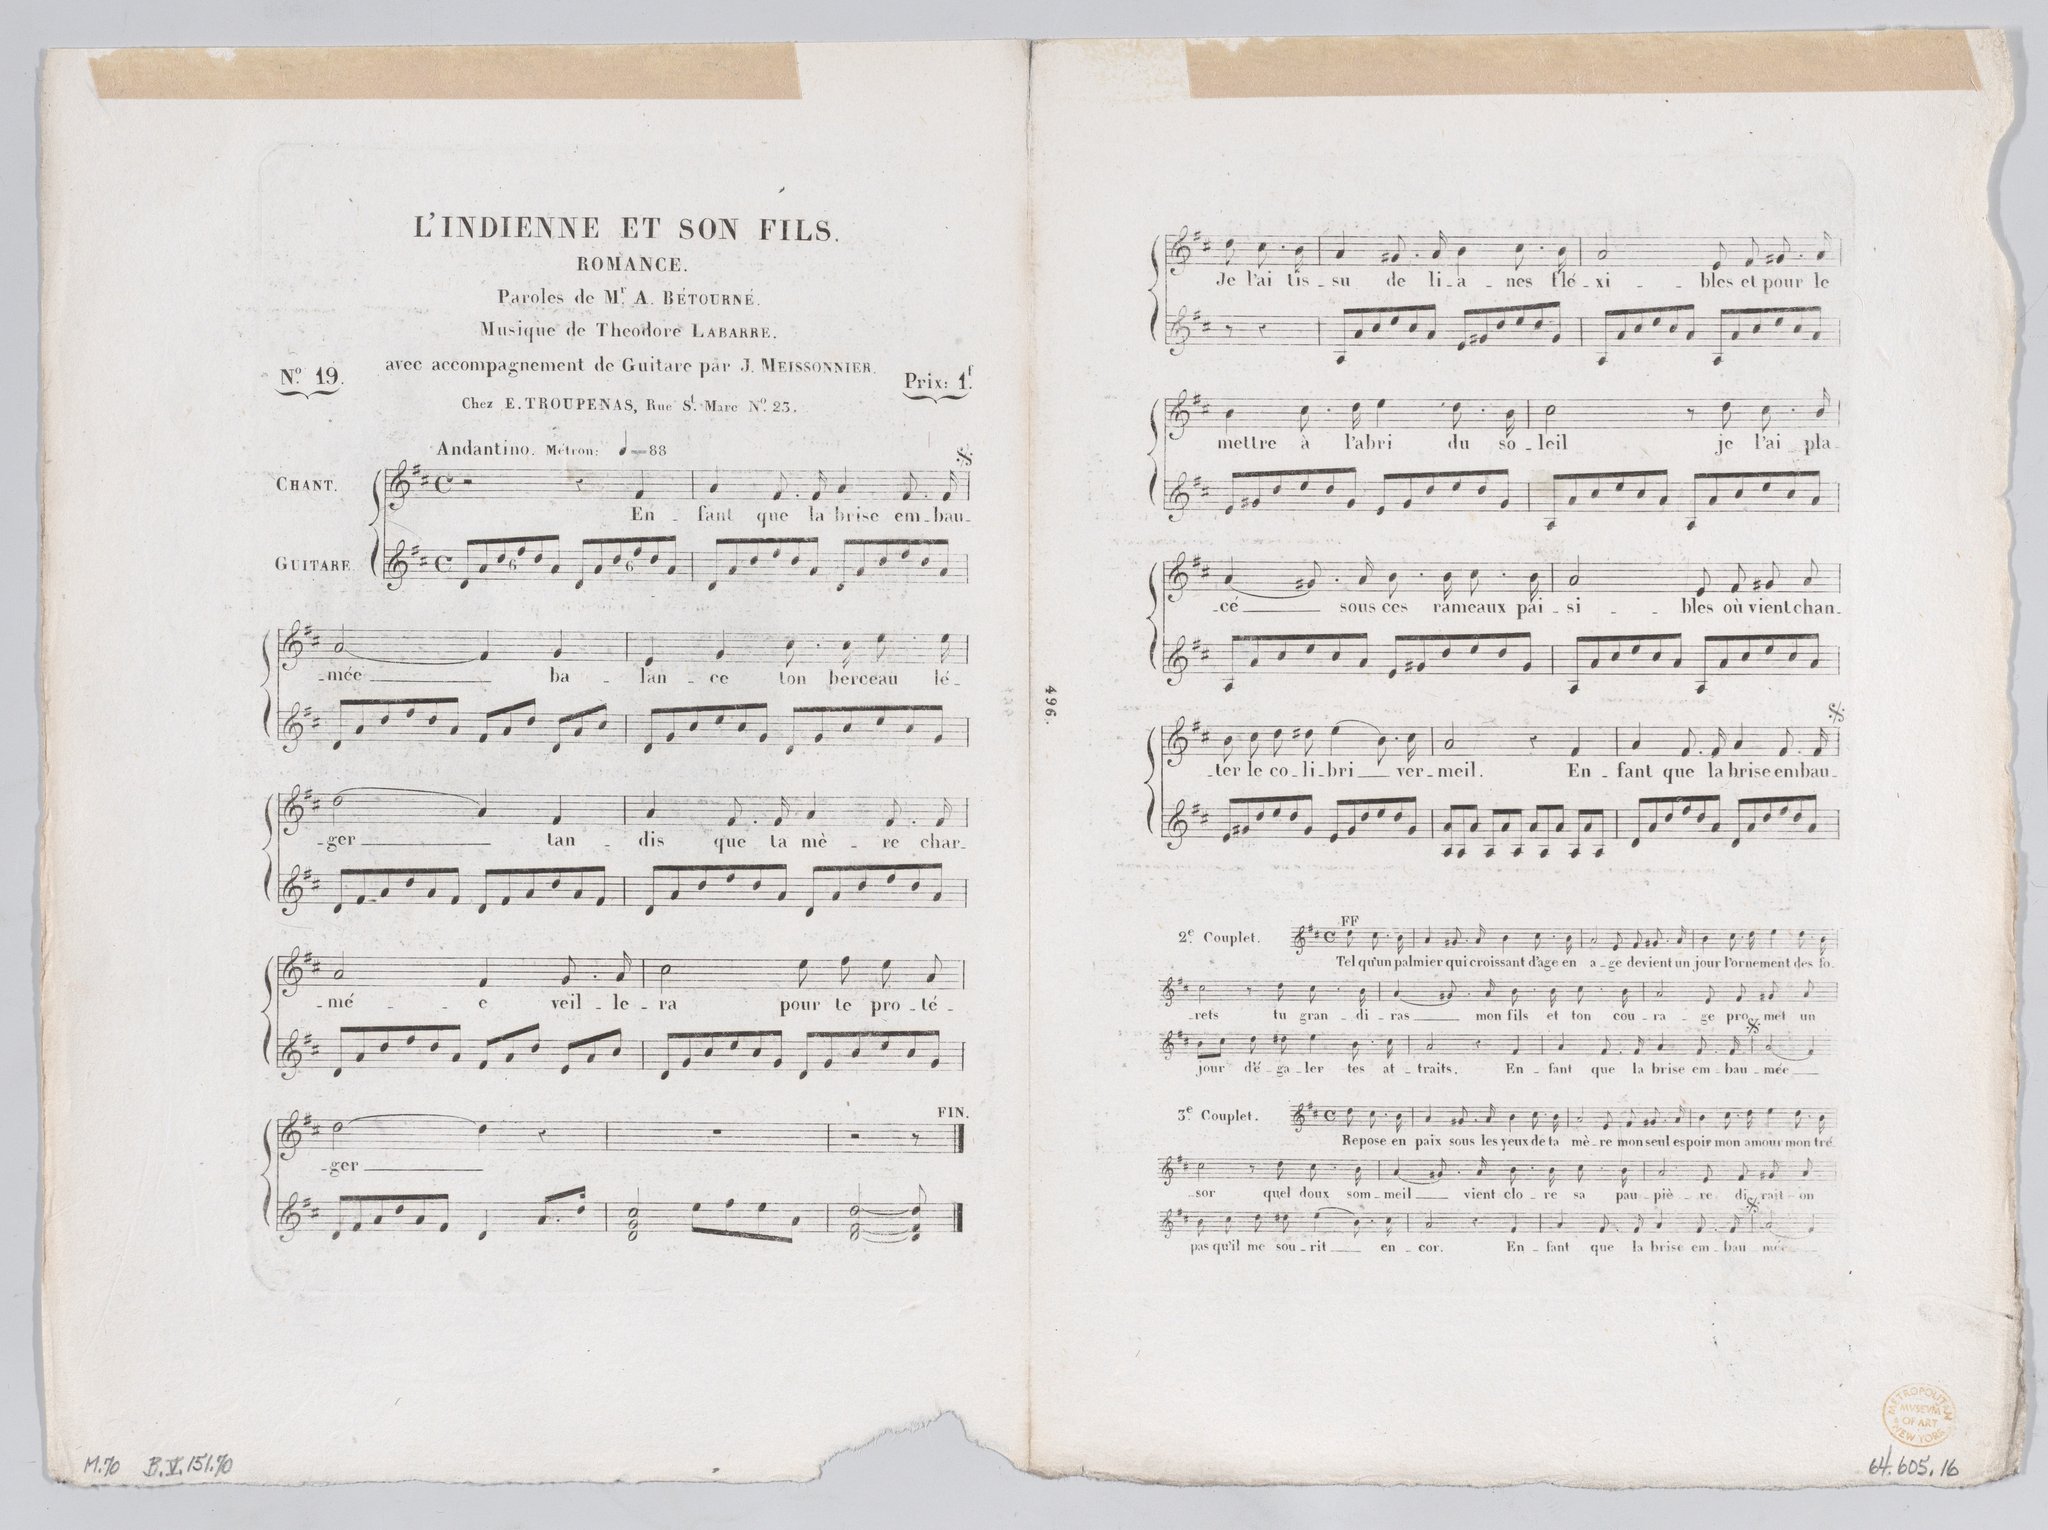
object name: print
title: An Indian Woman and Her Son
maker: alexandre-gabriel decamps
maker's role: artist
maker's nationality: french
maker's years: 1803-1860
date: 1830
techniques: lithograph